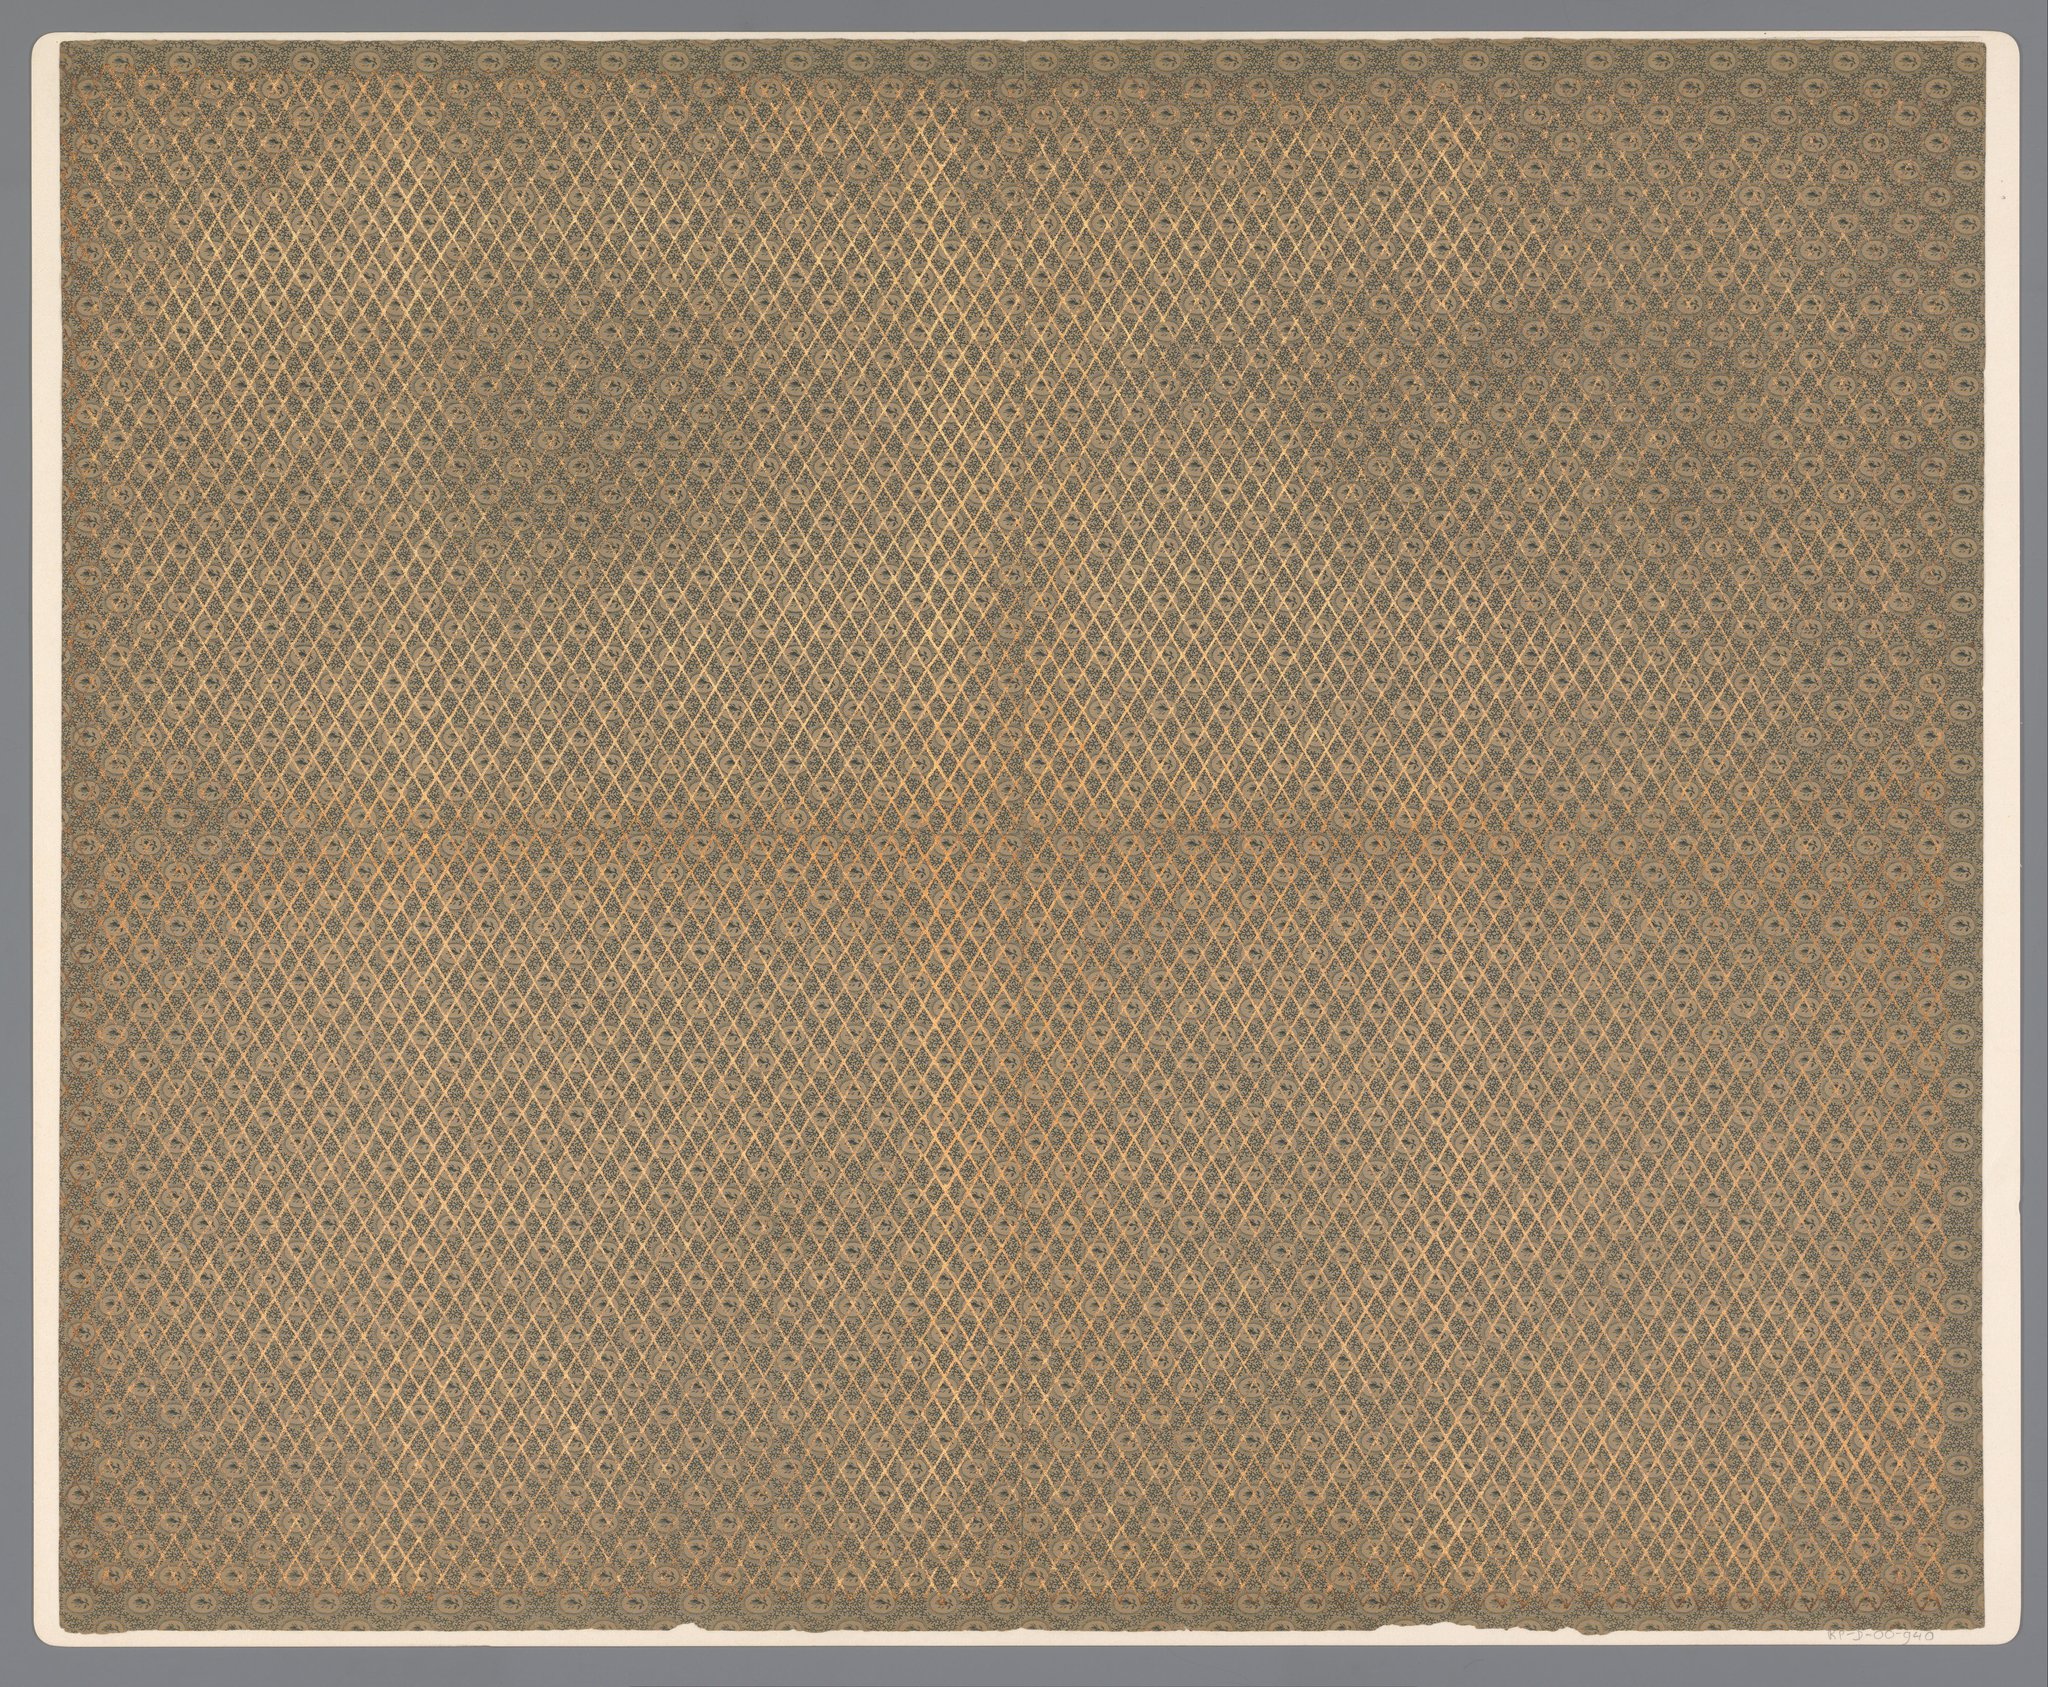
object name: embossed paper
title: Blad met strooipatroon van ovaal bloemmotief tussen takjes met ruitpatroon in goud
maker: Anonymous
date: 1900-1950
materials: paint, paper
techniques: machining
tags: ornament derived from plant forms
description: Blad met regelmatig strooipatroon van bloemmotief in ovaal omgeven door takjes in groen onder een ruitpatroon in goud.